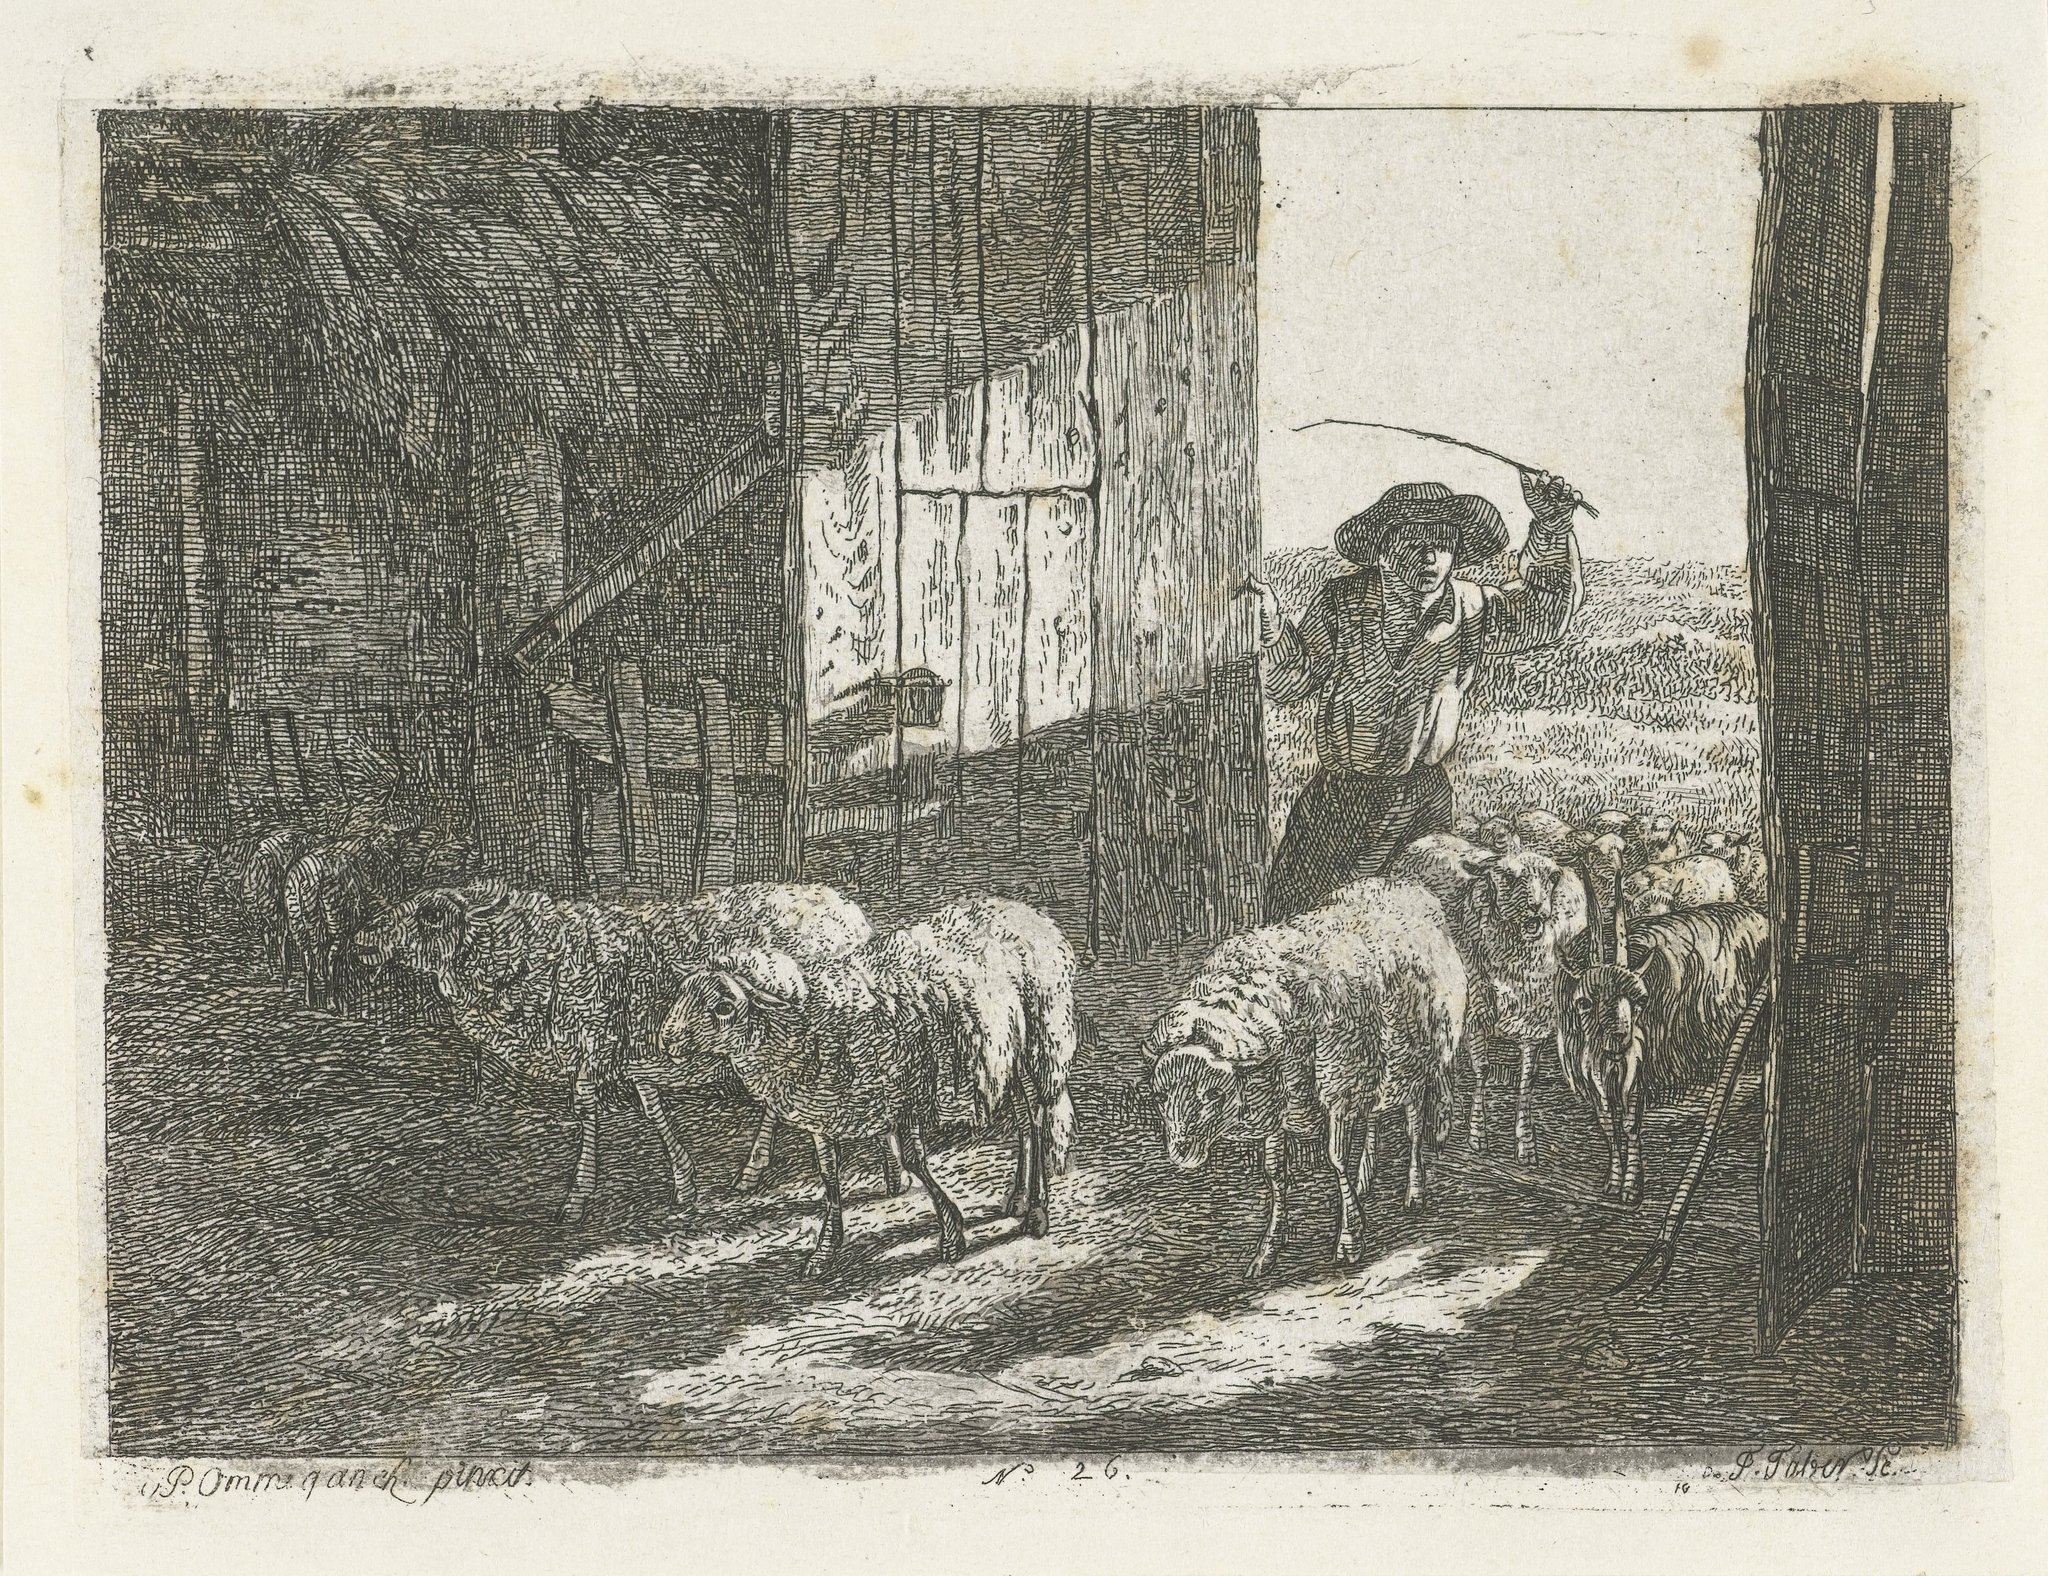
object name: print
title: Schaapkooi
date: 1806-1807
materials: paper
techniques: aquatint, etching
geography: antwerp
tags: sheep (+ indoors; in laboratory, factory, barn, etc.)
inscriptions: collector's mark: Lugt 2228, collector's mark: Lugt 1485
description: Een herder laat zijn kudde de schaapskooi in.